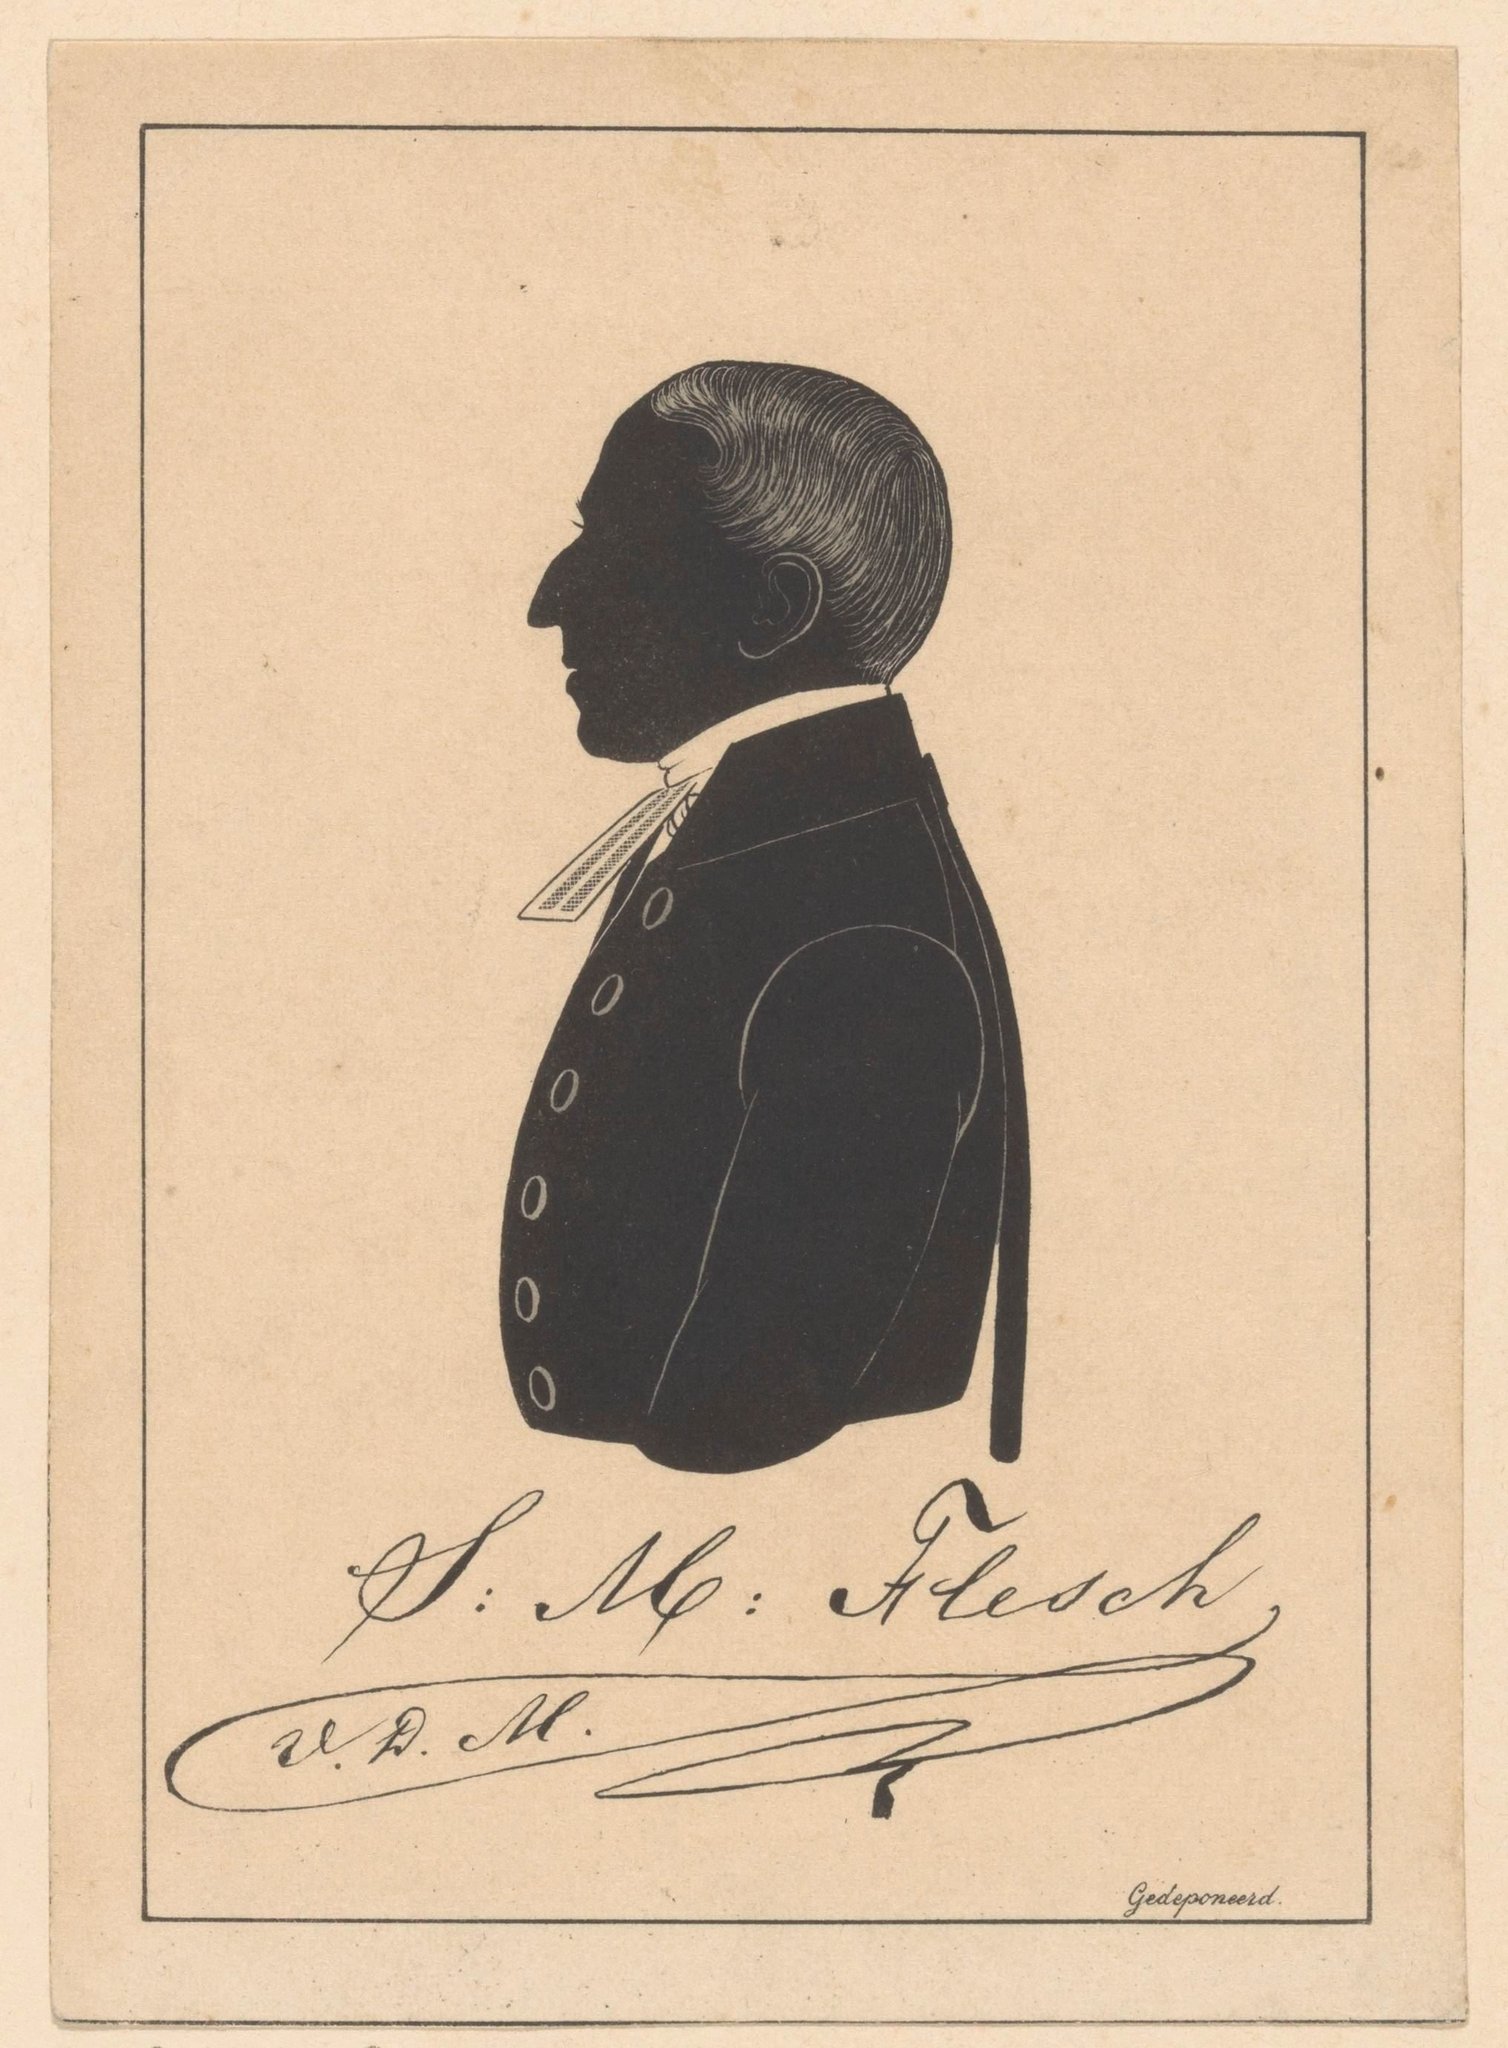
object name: print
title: Silhouetportret van Salomon Mozes Flesch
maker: pieter barbiers (iv)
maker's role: painter, print maker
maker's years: 1798-1848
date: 1809-1848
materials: paper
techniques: hand coloring, lithograph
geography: netherlands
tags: historical persons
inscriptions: : ‘Gedeponeerd.’, collector's mark: Lugt 2228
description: Onder het portret de signatuur van de geportretteerde.